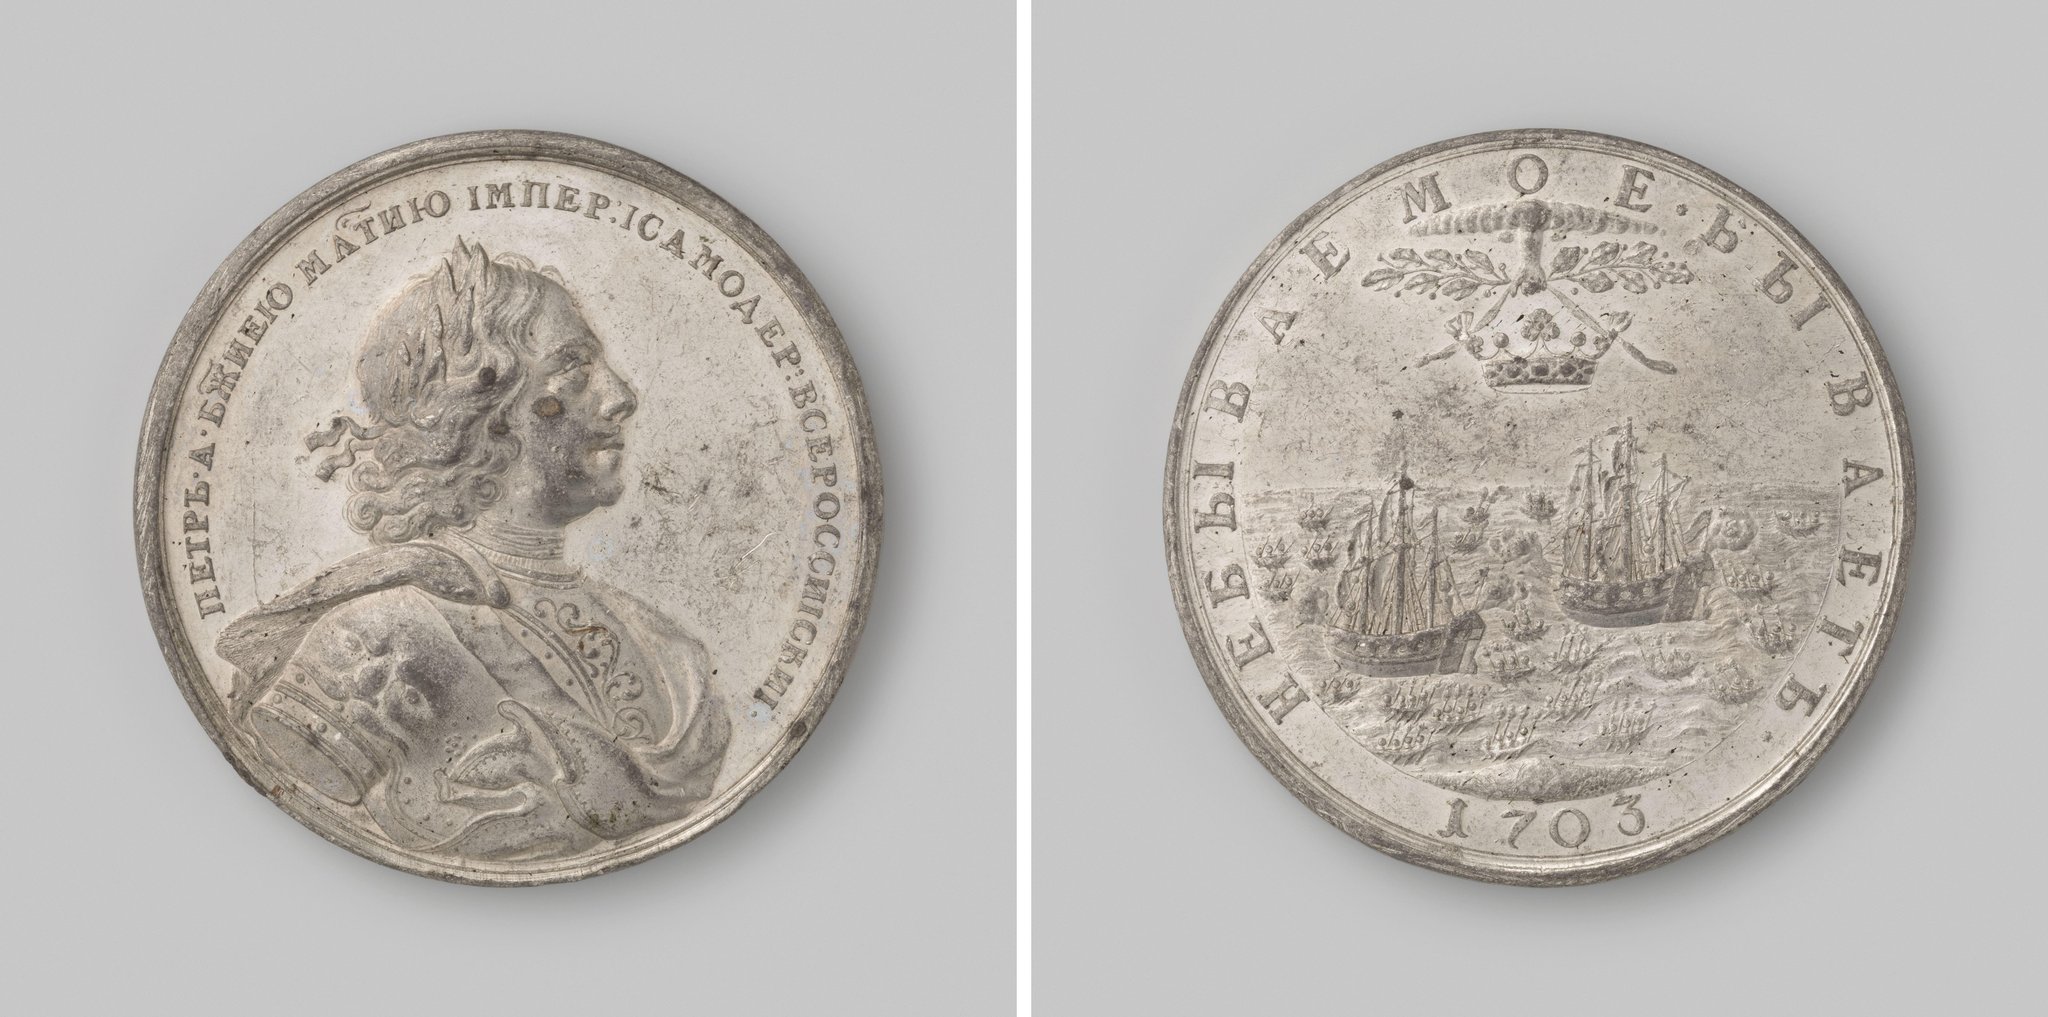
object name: history medal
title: Verovering door Rusland van twee Zweedse oorlogsschepen 1703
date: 1703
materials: tin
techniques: striking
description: Tinnen penning, op de voorzijde het borstbeeld van Tsaar Peter de Grote naar rechts met omschrift, op de keerzijde twee driemasters in een zee vol kleine scheepjes, waarboven een hand uit de wolken met een kroon en een krans, met omschrift en afsnedetekst.